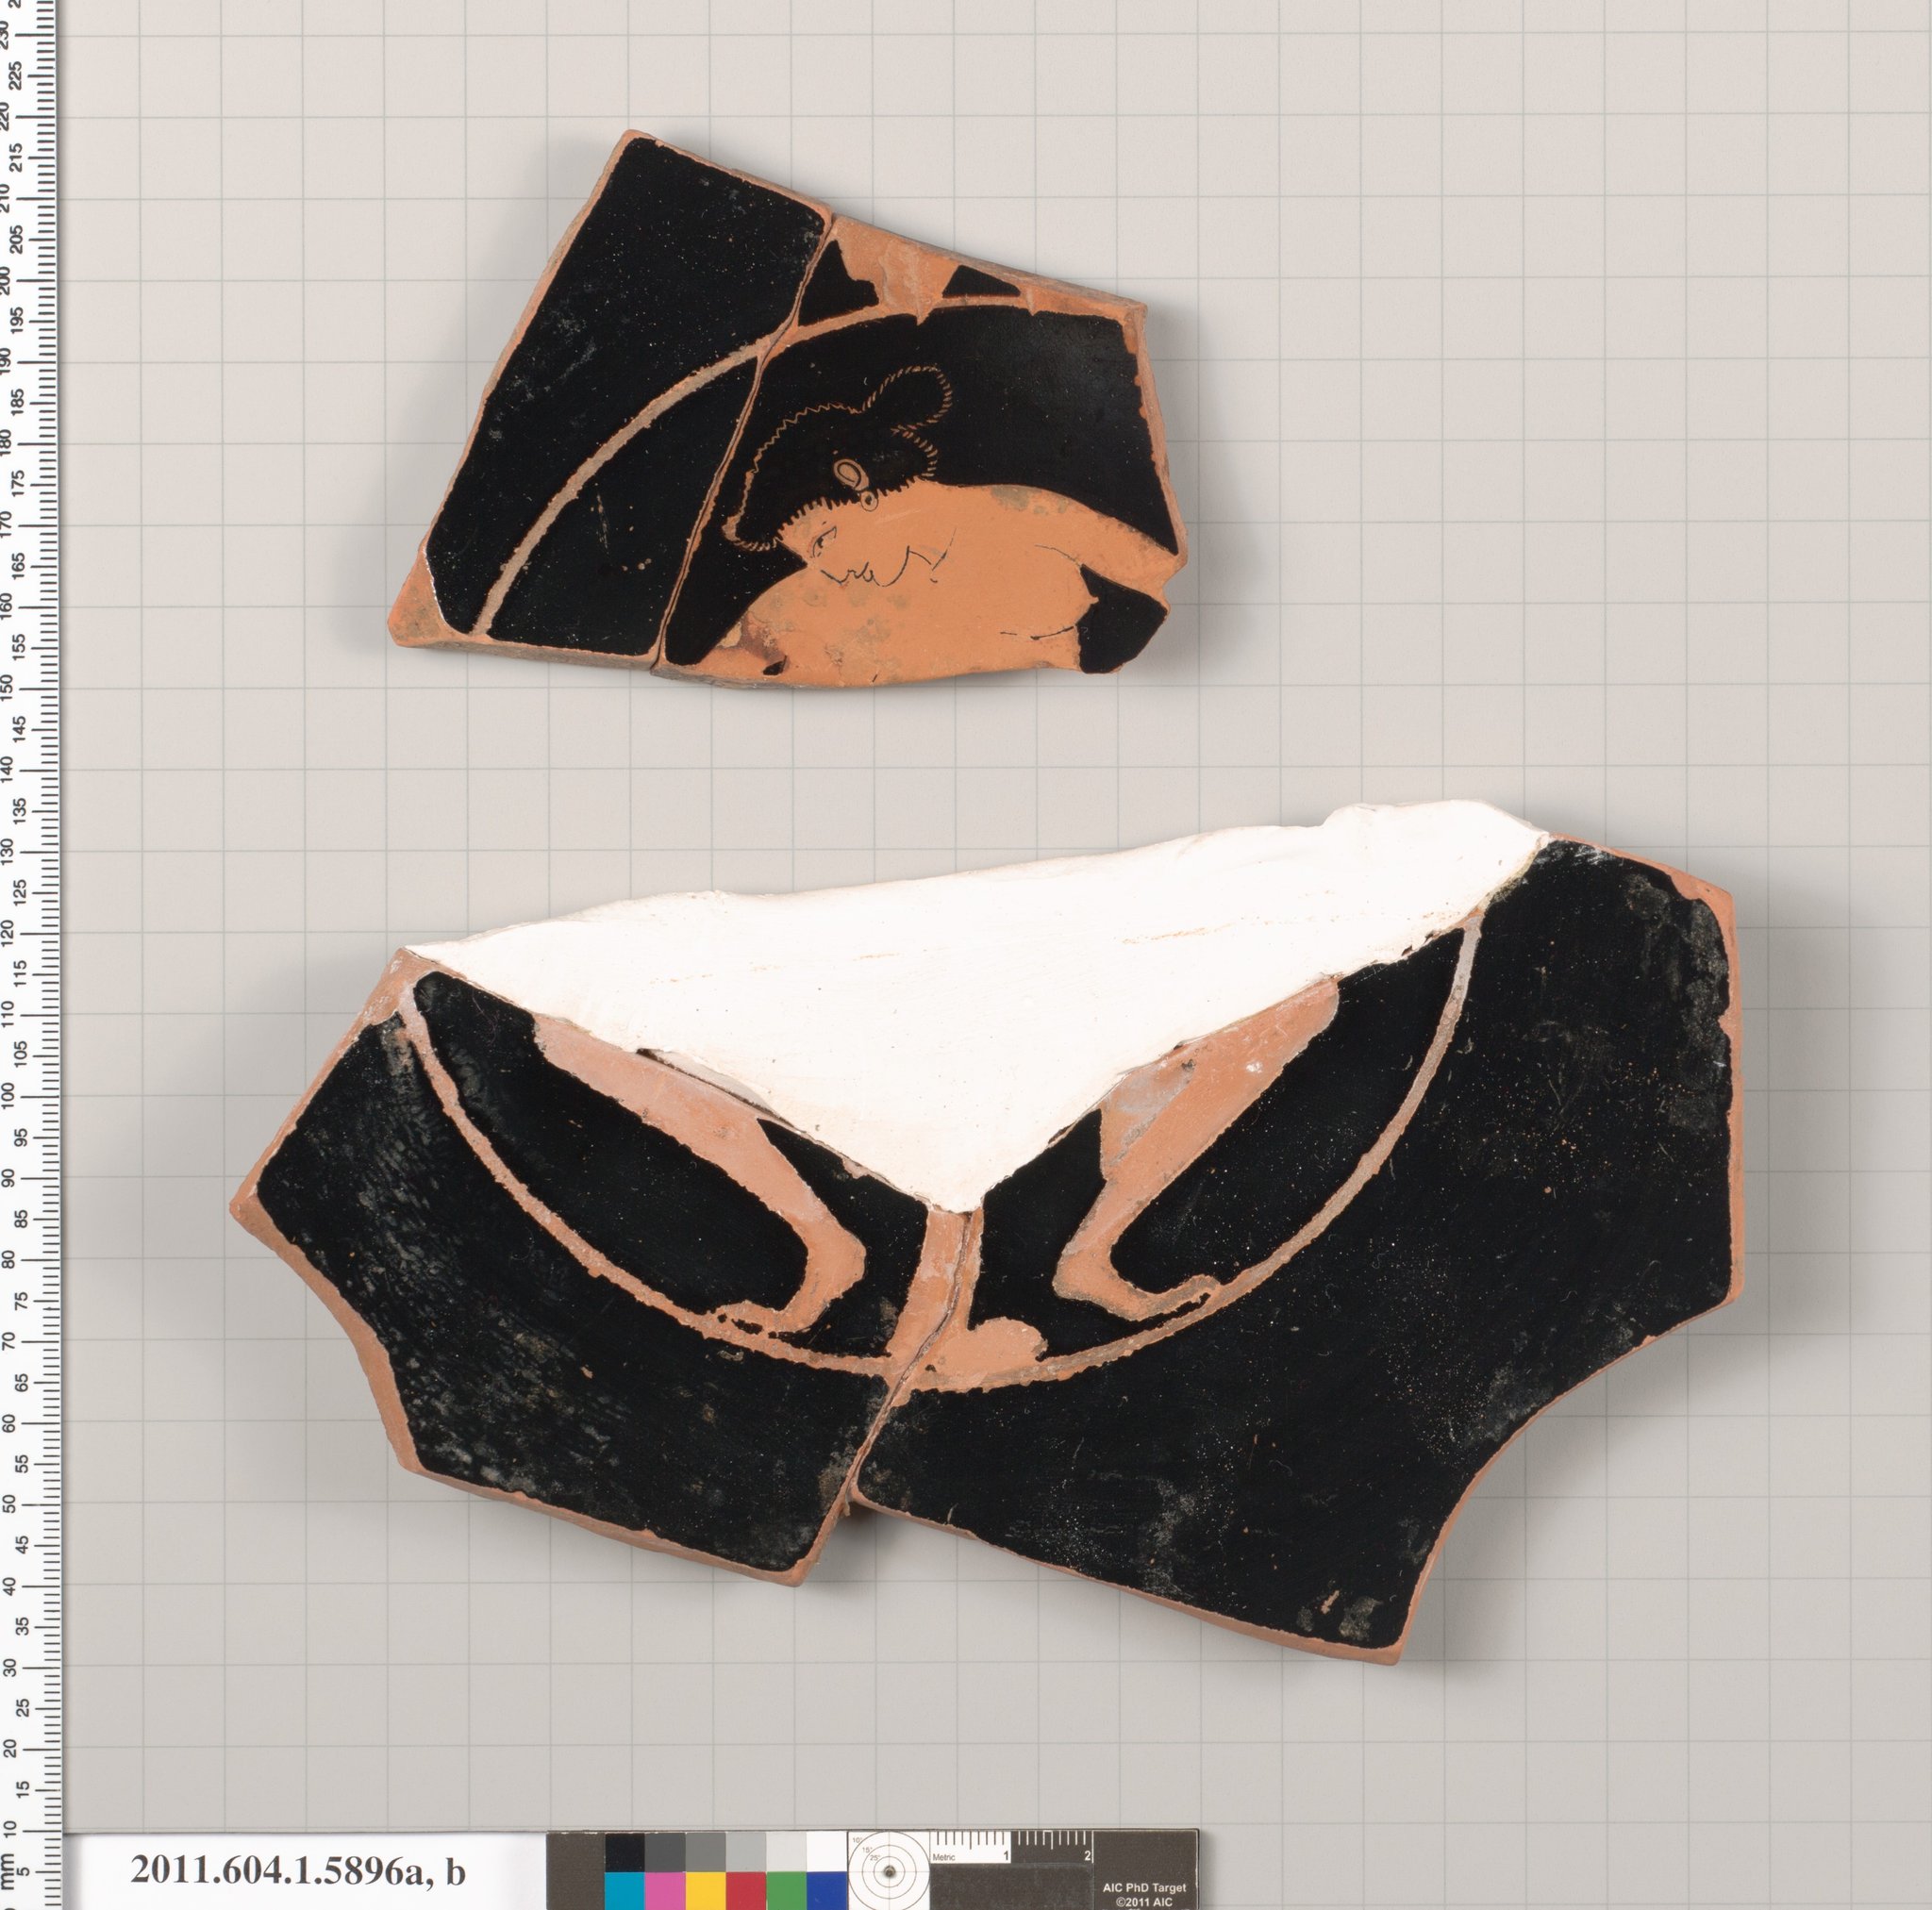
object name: kylix fragment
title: Terracotta fragments of a kylix (drinking cup)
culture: greek, attic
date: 520-510 BCE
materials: terracotta